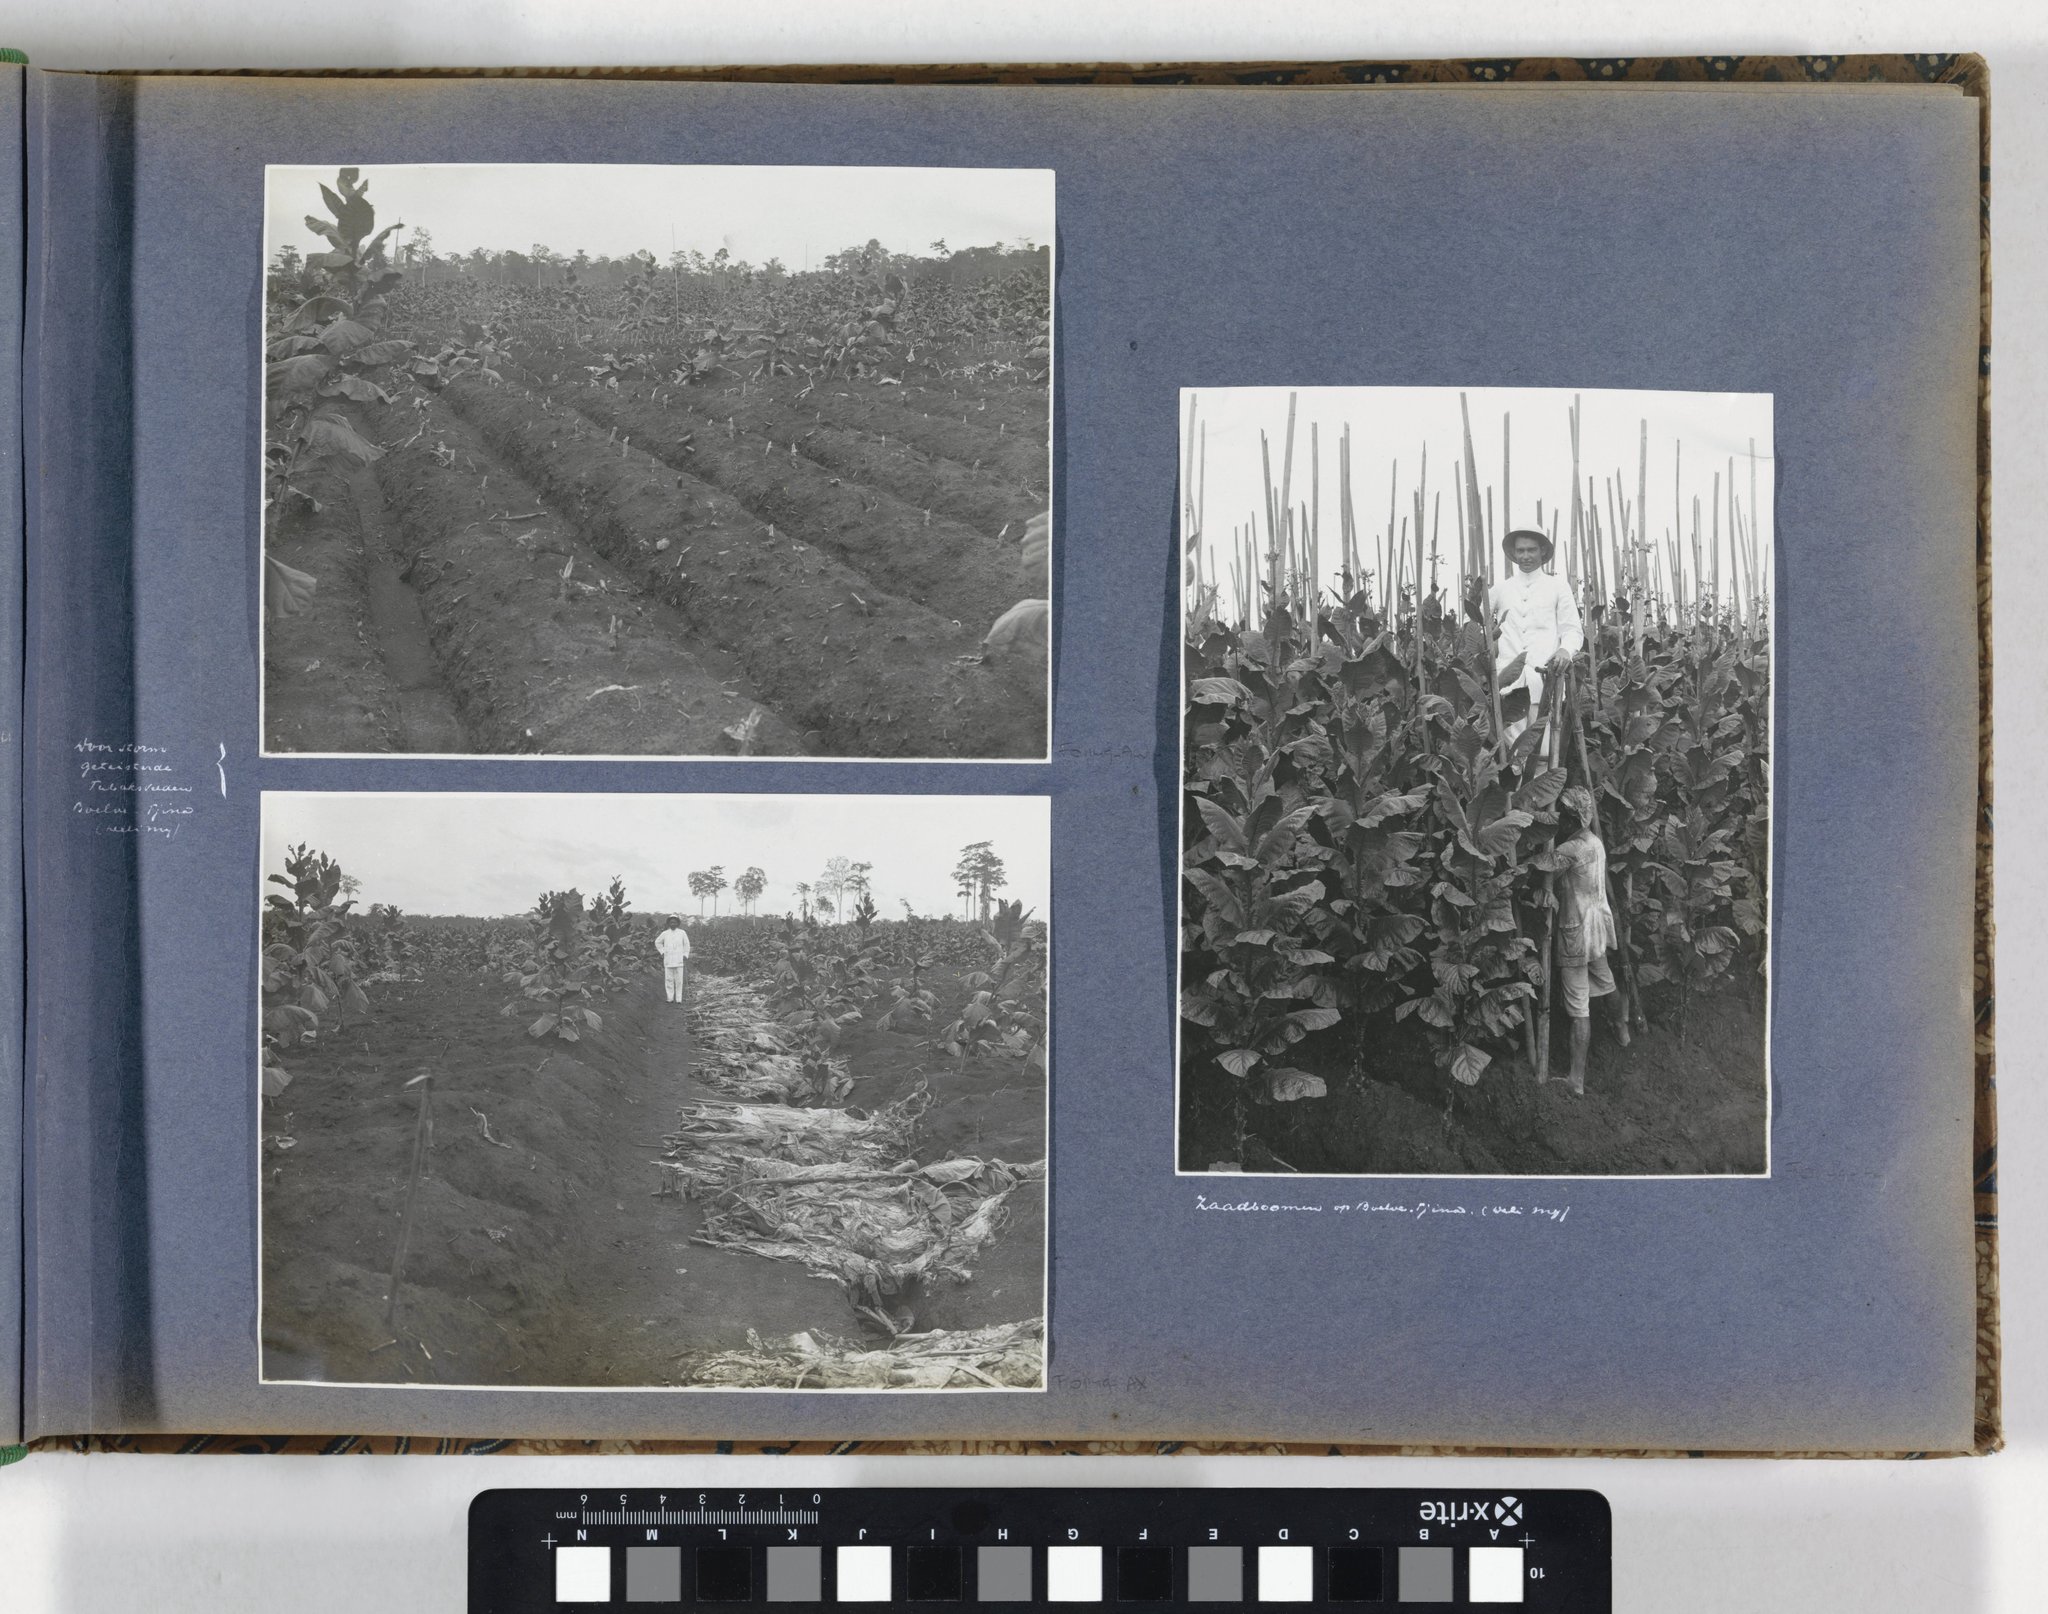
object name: album leaf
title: Door storm geteisterde velden van tabaksplantage Boeloe Tjina op Sumatra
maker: Anonymous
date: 1900-1920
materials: paper, photographic support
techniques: gelatin silver print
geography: sumatra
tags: plantation, tobacco, sumatra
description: Onderdeel van reisalbum met foto's van bedrijvigheid en bezienswaardigheden op Sumatra en Java en van de reis naar en van Nederlands-Indië.